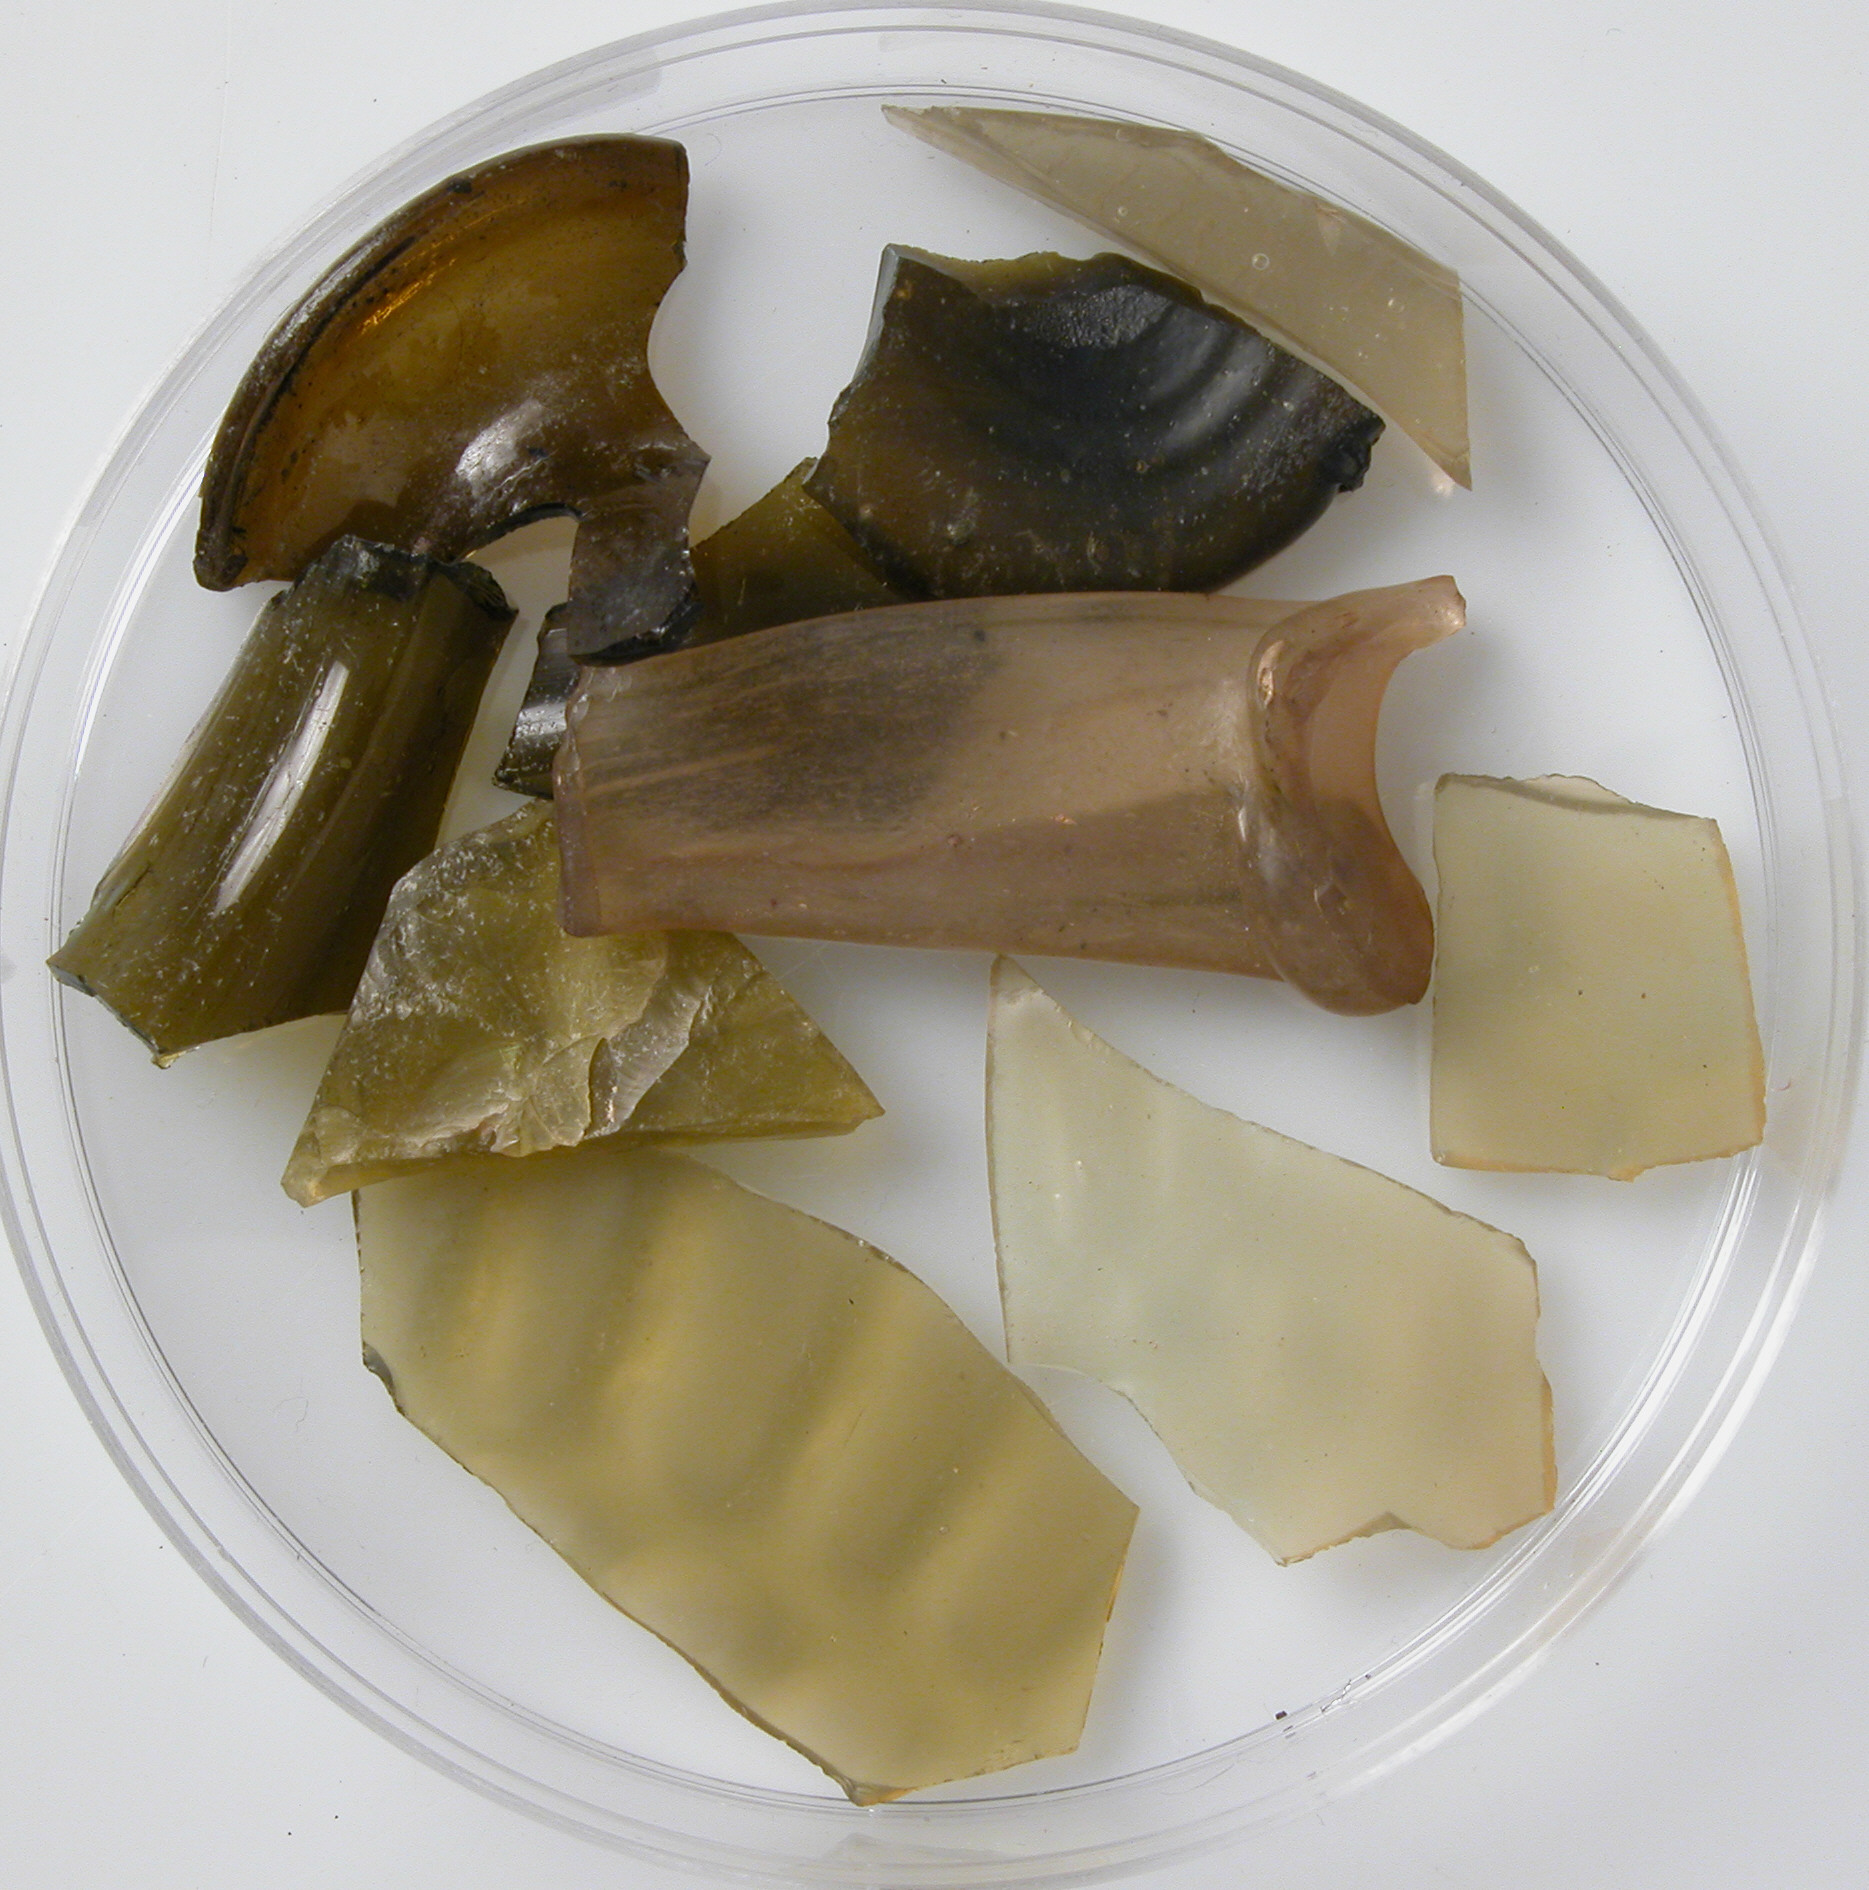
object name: fragment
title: Glass Fragments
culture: coptic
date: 301-700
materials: glass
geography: egypt